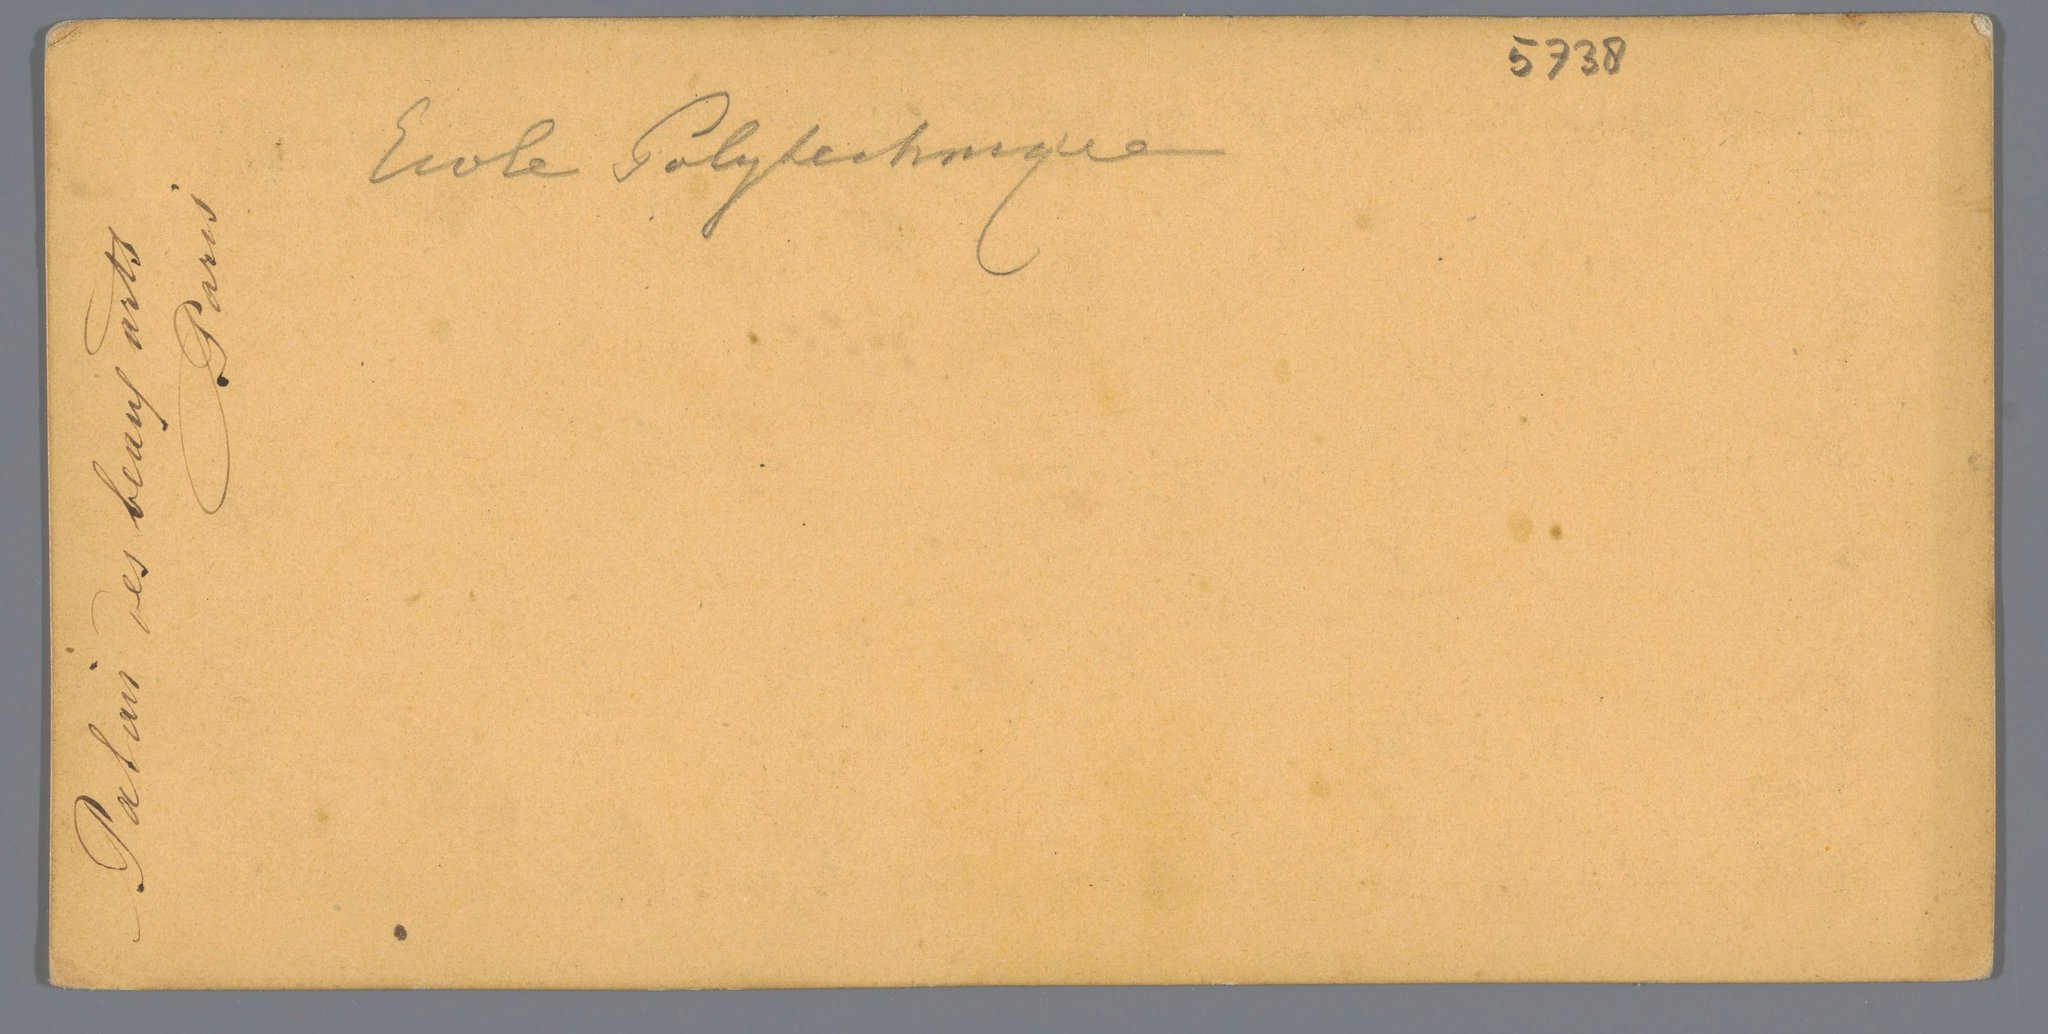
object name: stereograph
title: Gezicht op de École nationale supérieure des beaux-arts in Parijs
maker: Anonymous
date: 1850-1880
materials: cardboard, photographic support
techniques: albumen print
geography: paris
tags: place or institution of education and training of the artist, e.g.: academy of art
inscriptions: inscription: ‘Palais des beaux arts Paris, Ecole Polytechnique’